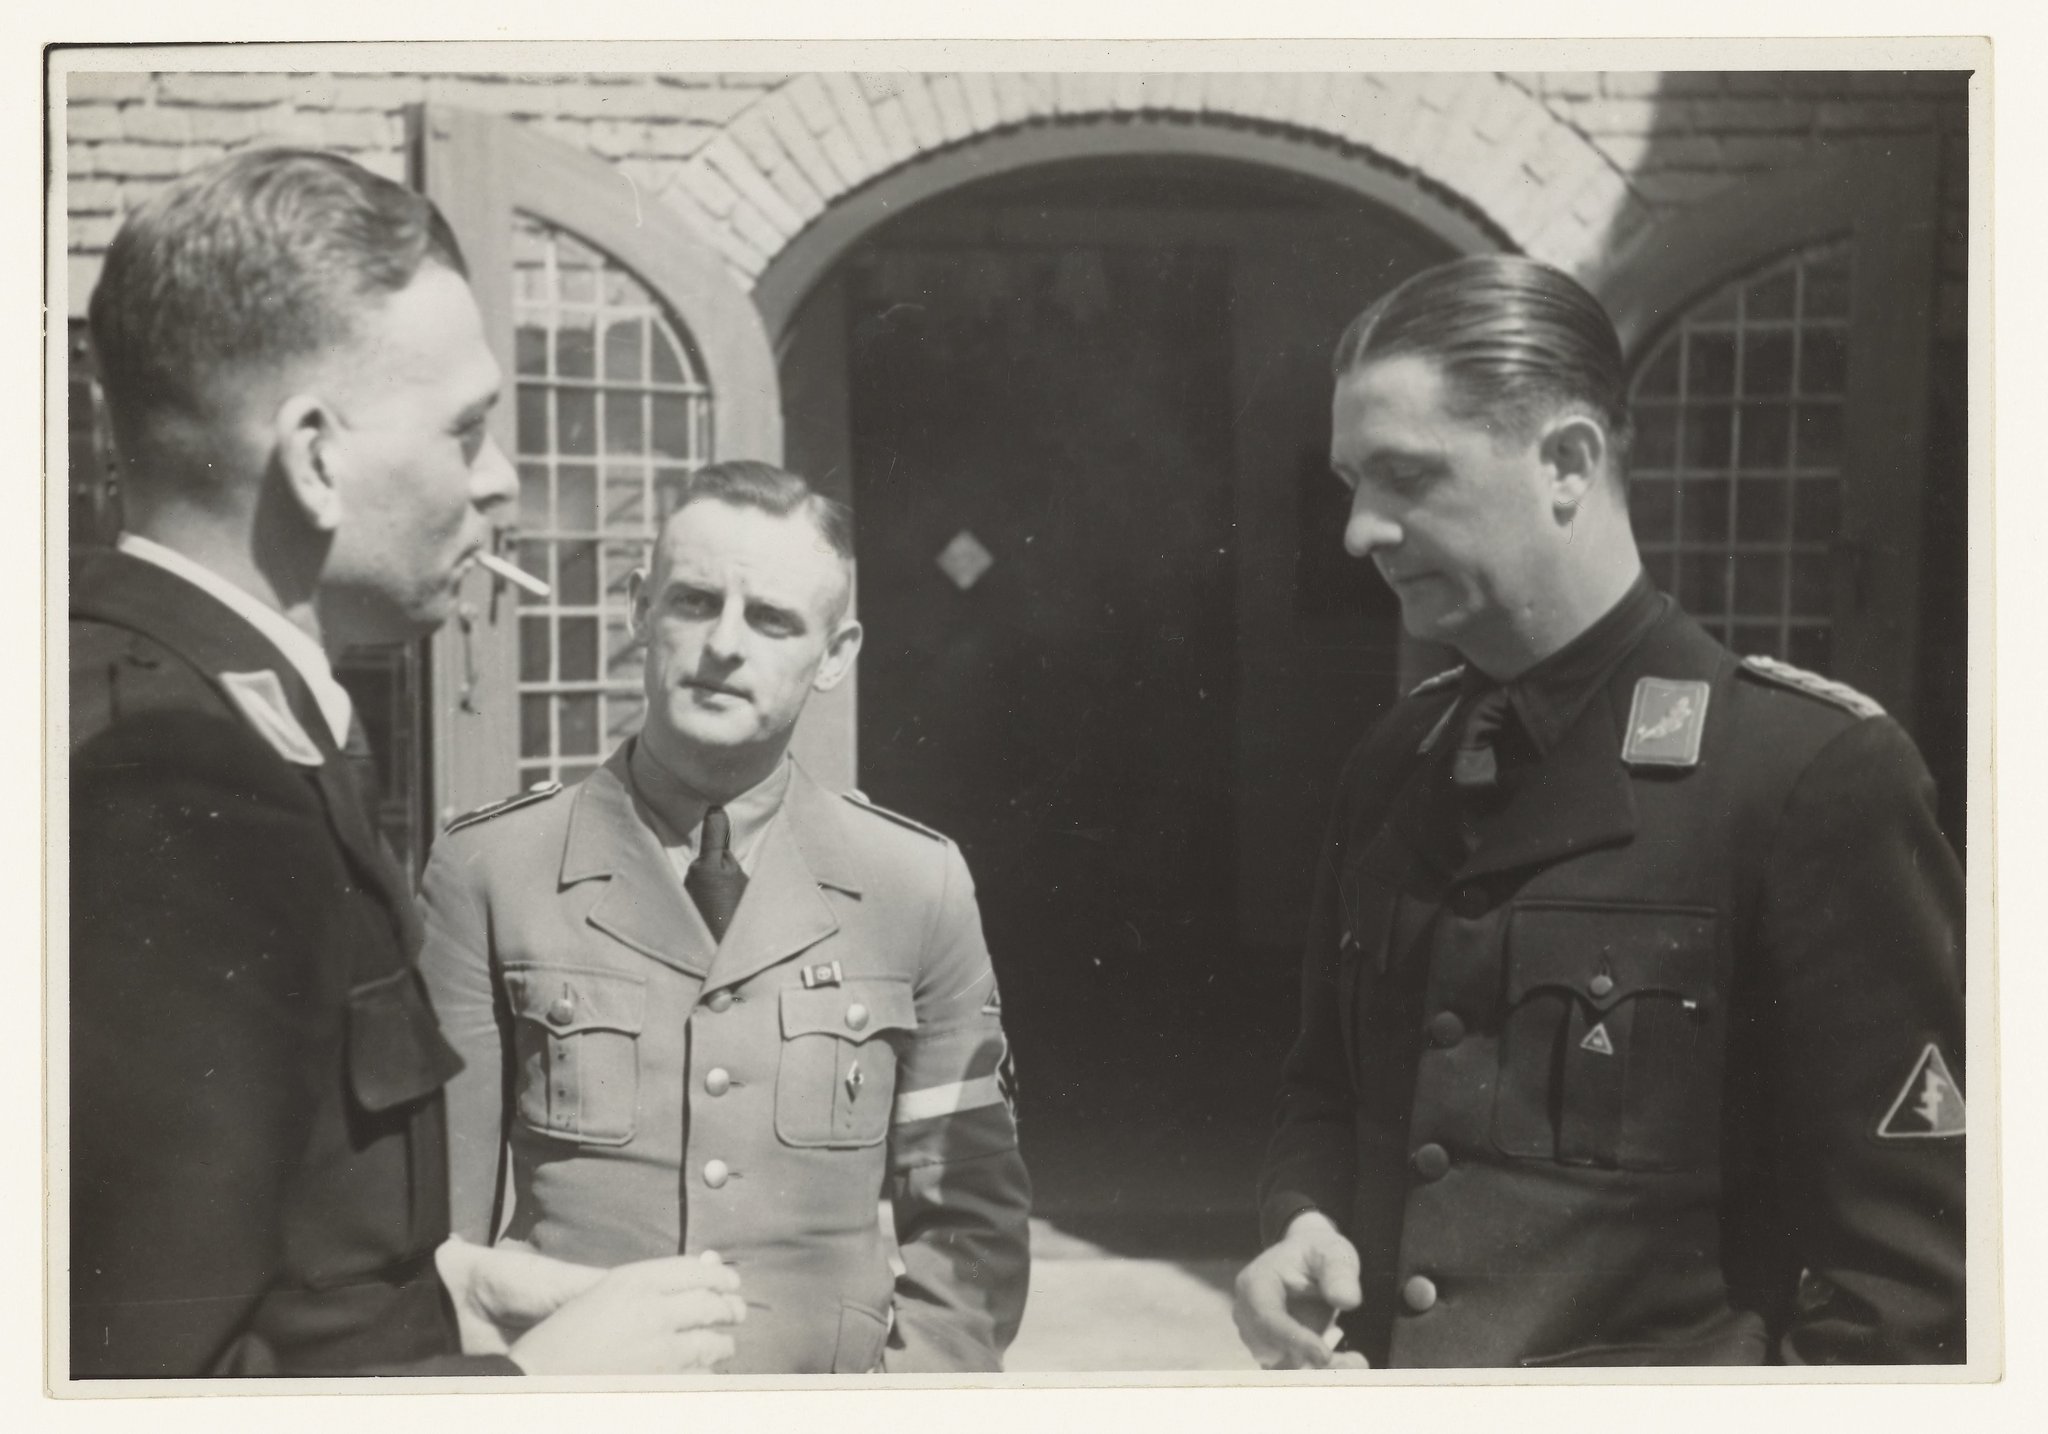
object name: photograph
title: WA Heerbanleider Meulenberg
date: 1942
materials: photographic support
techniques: gelatin silver print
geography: the hague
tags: political meeting, propaganda meeting, the hague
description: WA Heerbanleider Meulenberg, rechts in WA uniform, spreekt met een Duitser in uniform en een lid van de NSB tijdens een kort bezoek van een groep Duitsers aan Den Haag.